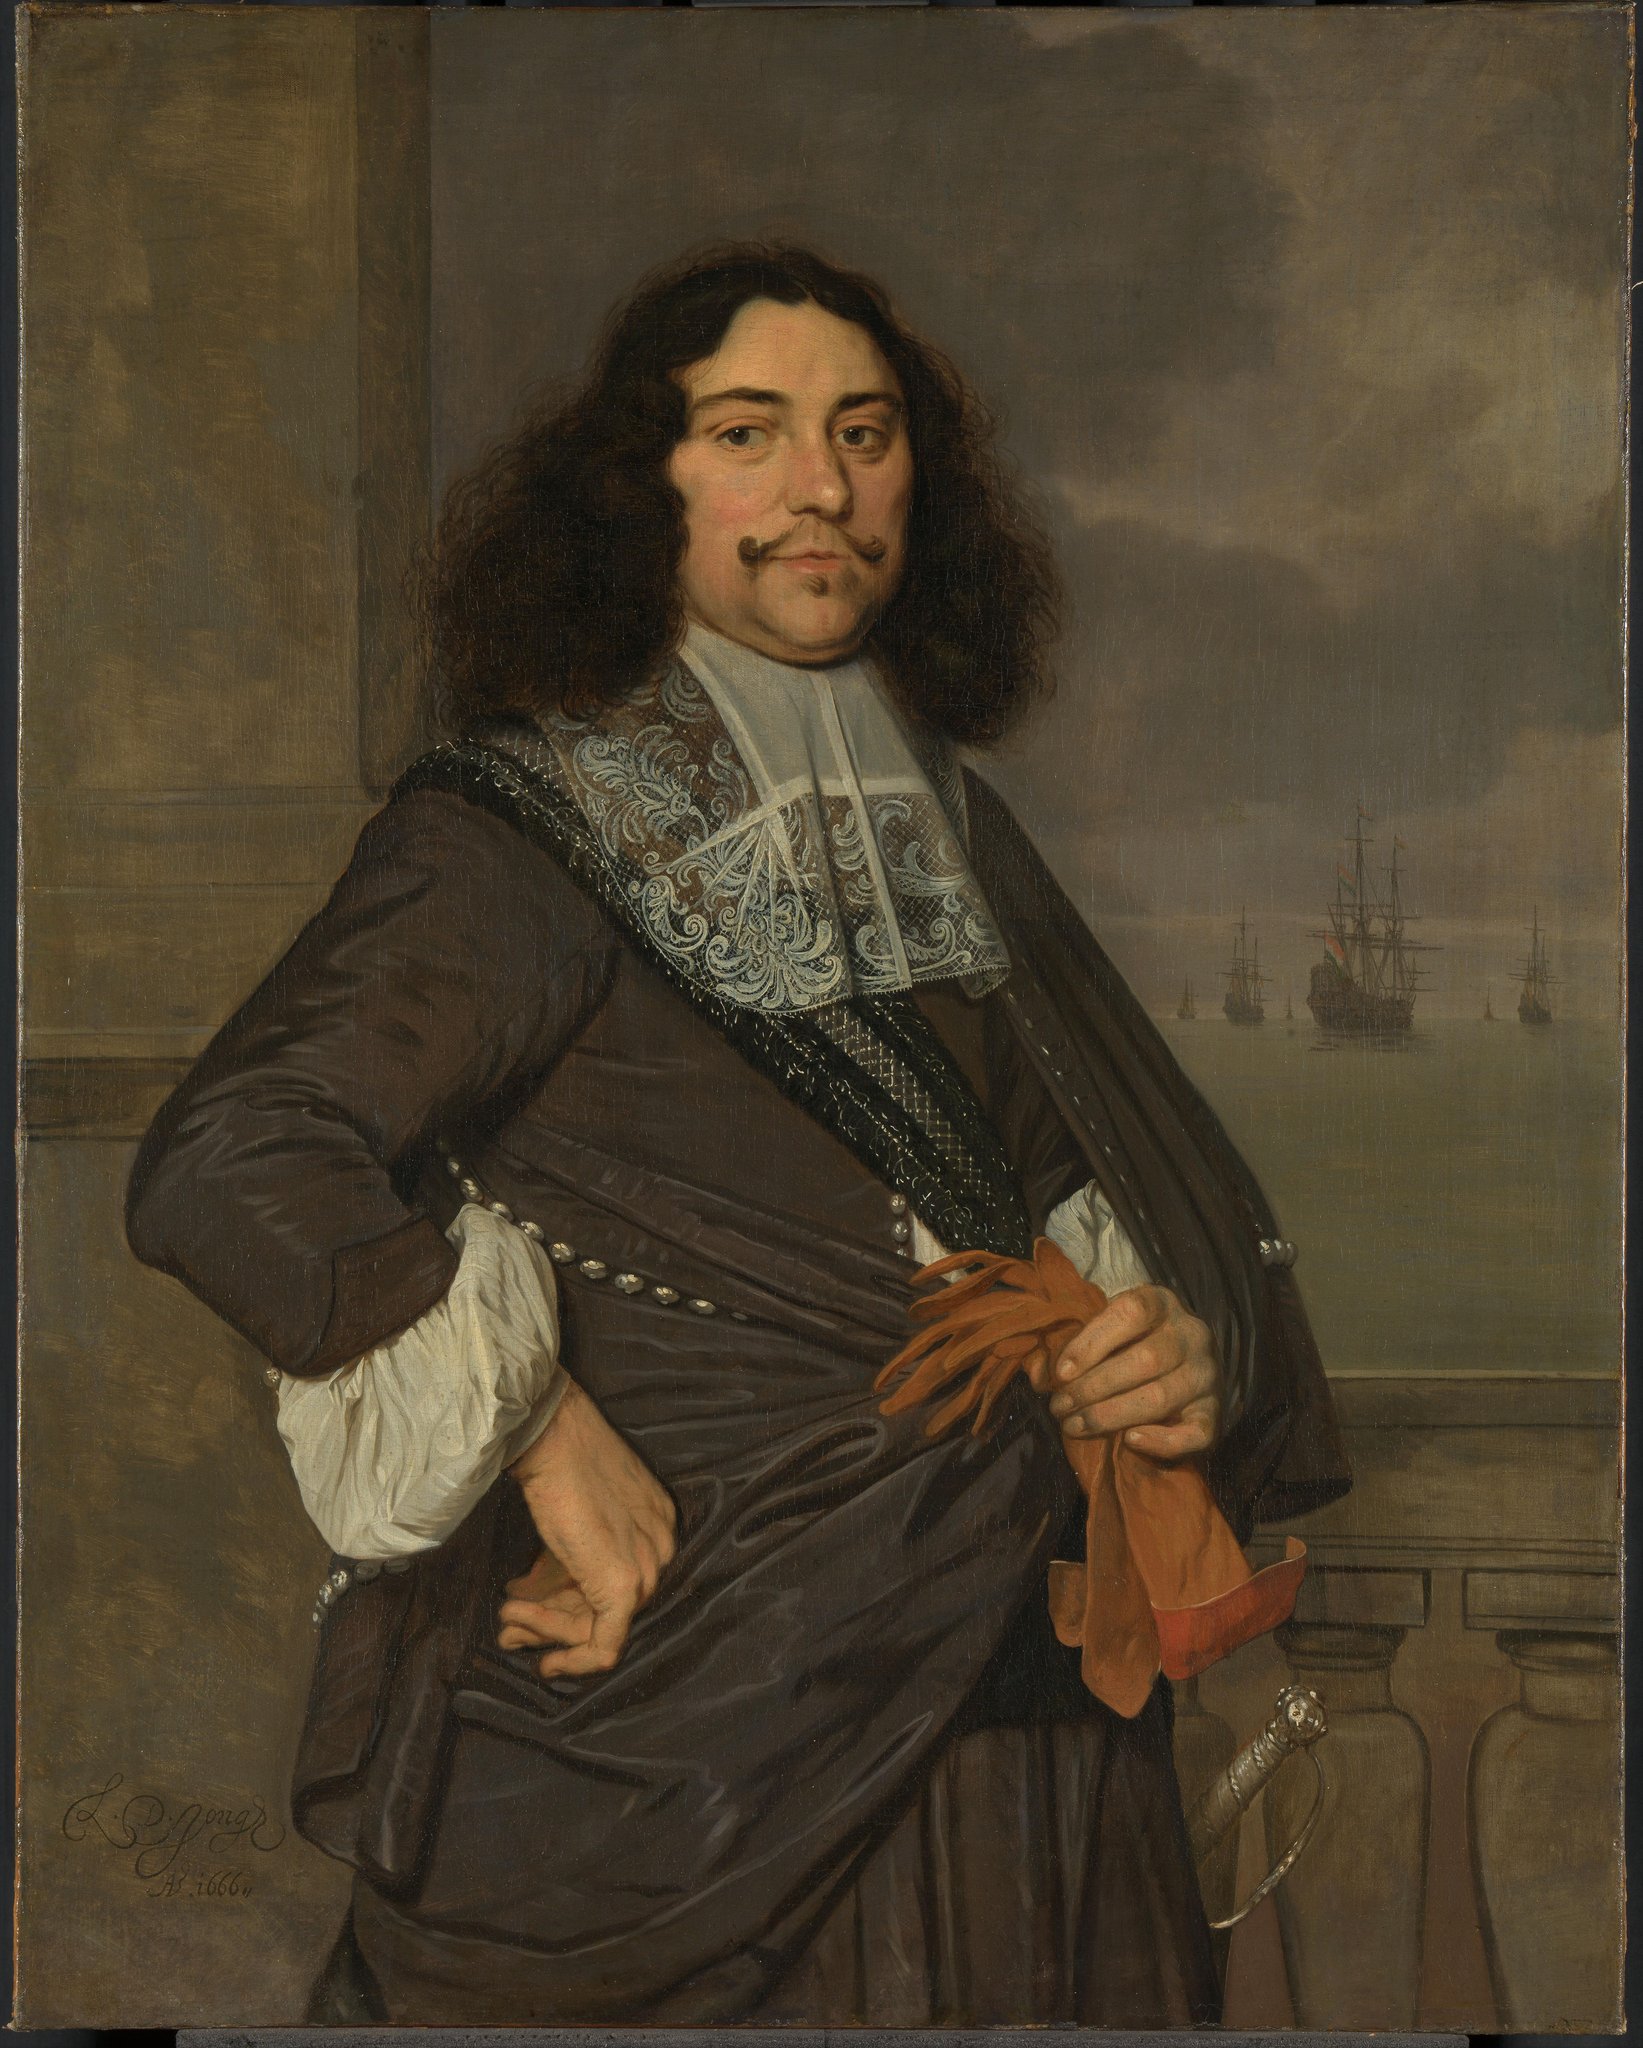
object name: painting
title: Jan van Nes (1631-80), Vice admiral of Holland and West-Friesland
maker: ludolf de jongh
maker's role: painter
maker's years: 1616-1679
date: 1666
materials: canvas, oil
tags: rotterdam, historical persons, commander-in-chief, admiral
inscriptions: signature and date: ‘L. D. Jongh Aº 1666’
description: Portret van Jan van Nes, vice-admiraal van Holland en West-Friesland. Staande, ten halven lijve, voor een balustrade. Handschoenen in de linkerhand, de rechterhand in de zij. Op de achtergrond rechts een zeegezicht met oorlogsbodems in stil water. Pendant van SK-A-197.